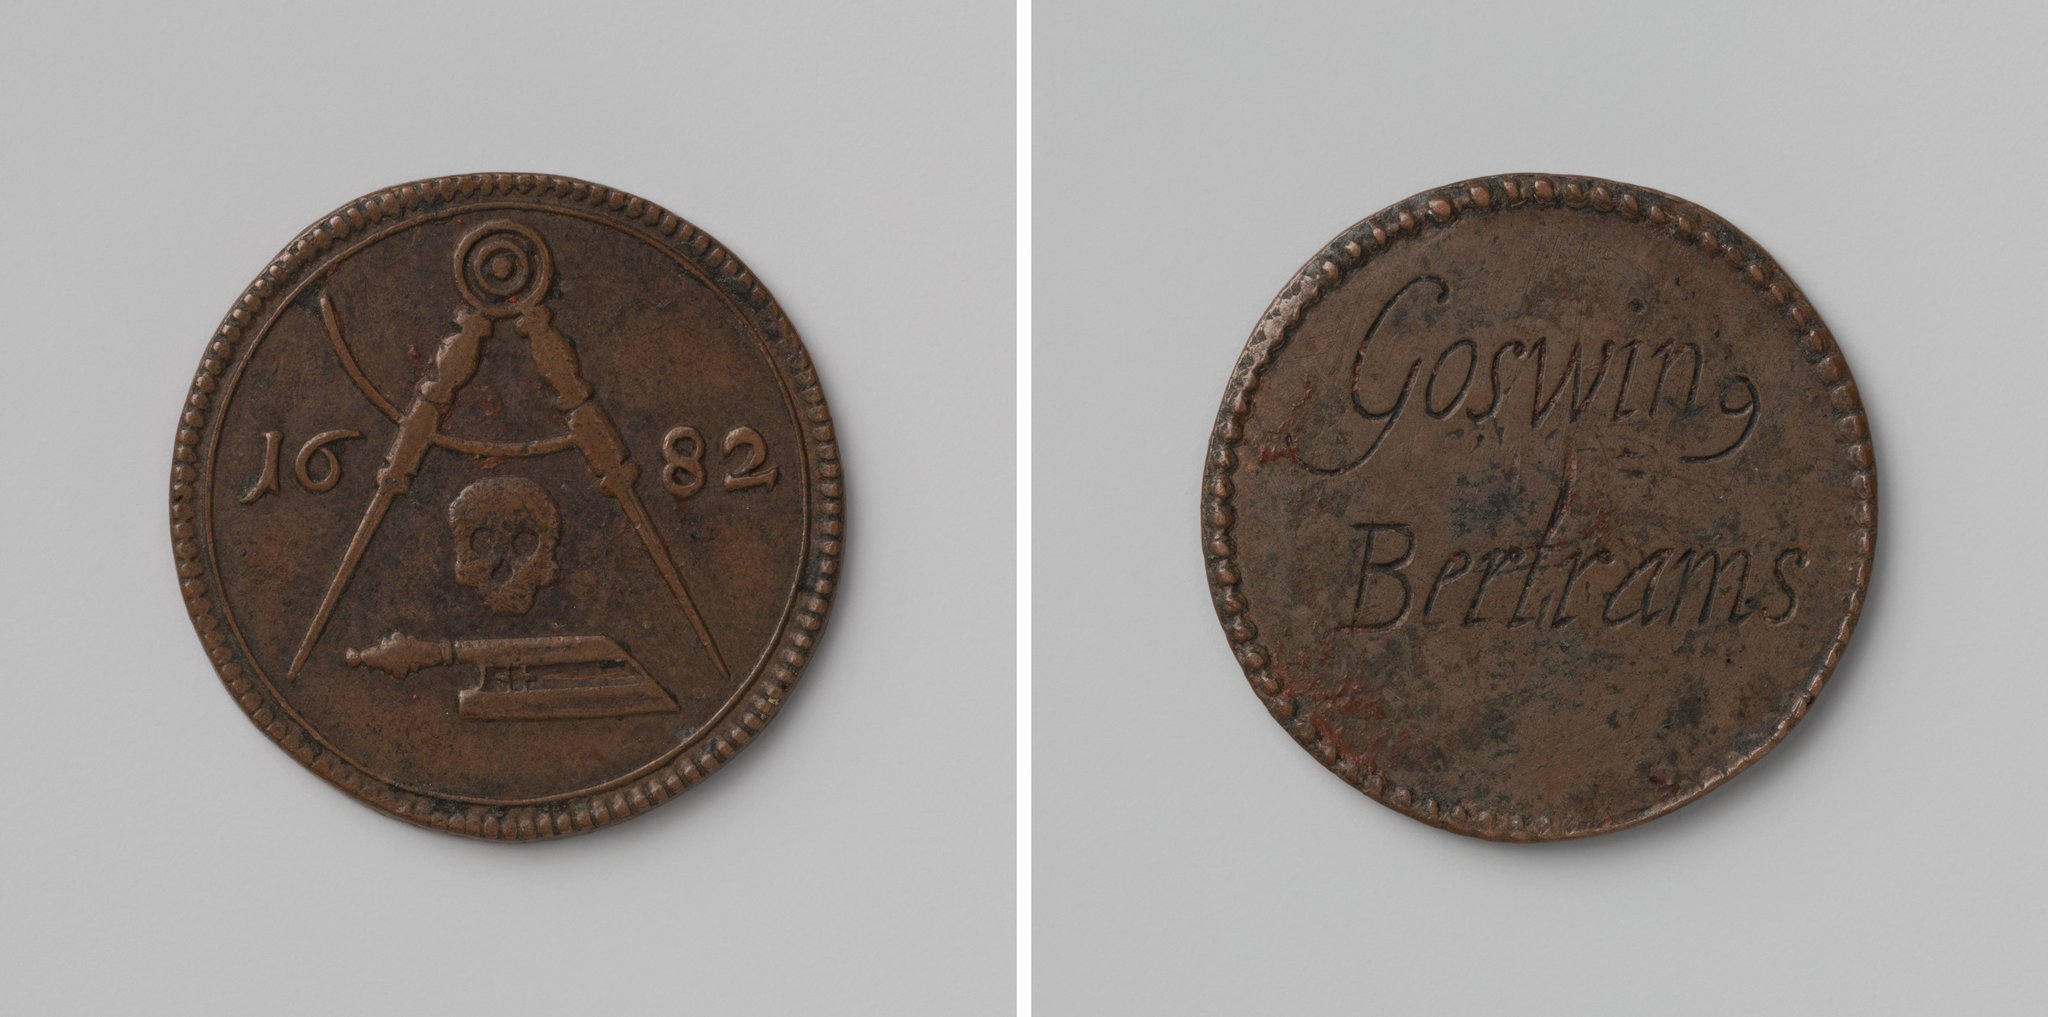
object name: funeral token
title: Timmerliedengilde van Keulen, begrafenispenning van Goswin Bertrams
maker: Anonymous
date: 1682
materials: copper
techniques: engraving, striking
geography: cologne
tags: cologne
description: Koperen penning. Voorzijde: geopende passer tussen jaartal; tussen benen: doodshoofd boven hakbijl. Keerzijde: opschrift